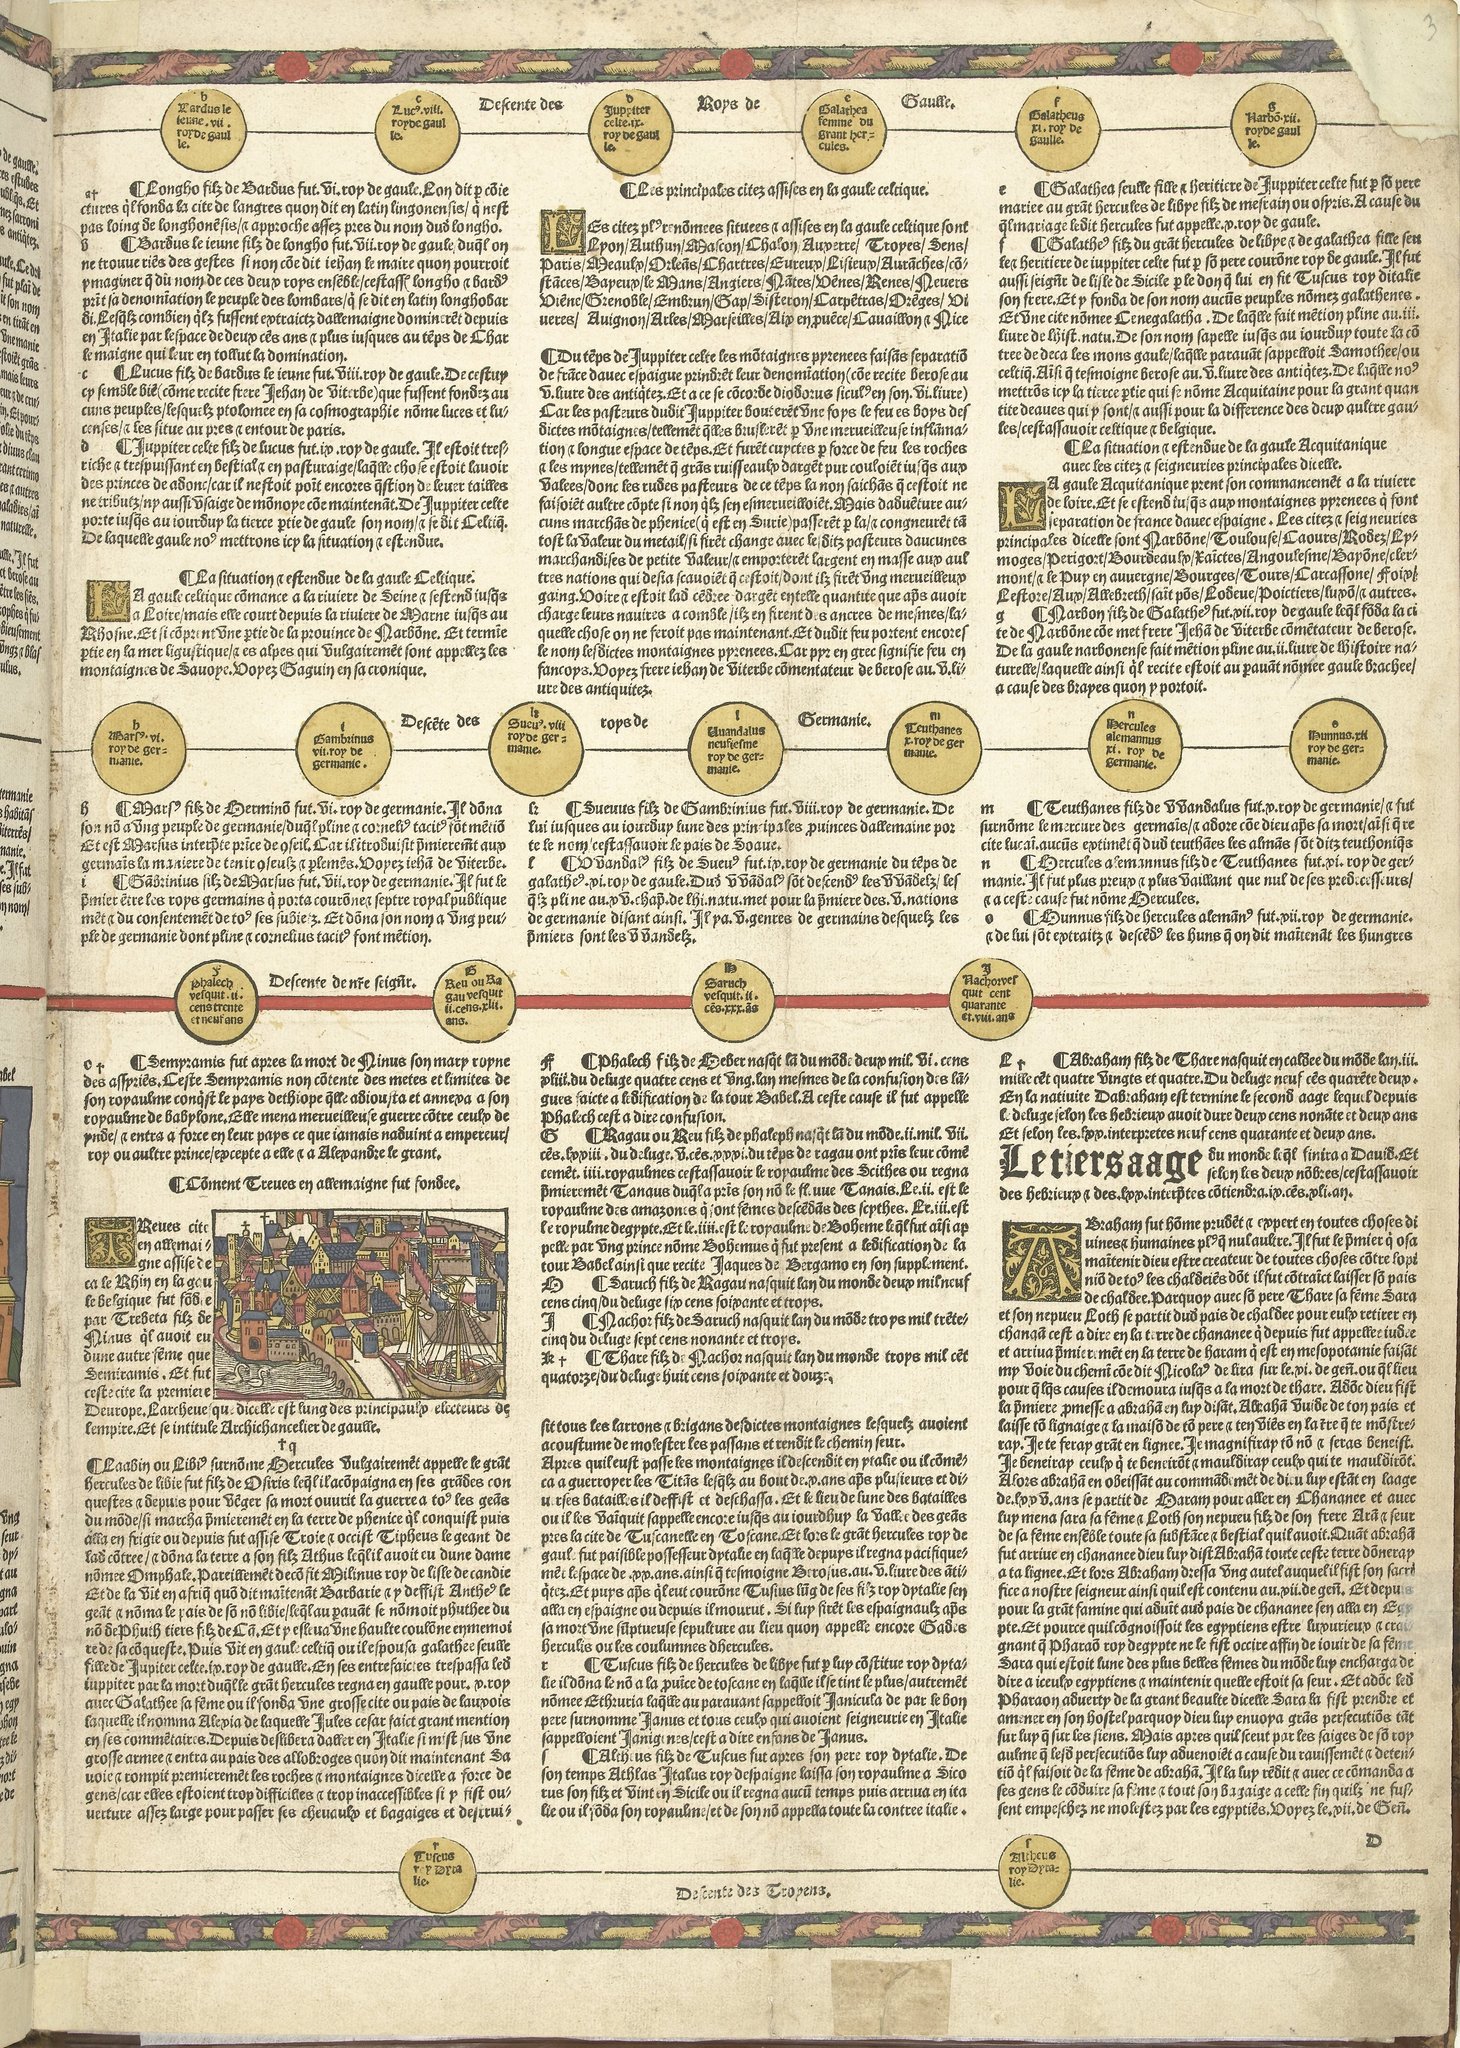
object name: album leaf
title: Cronica Cronicarum (...), blad 3 recto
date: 1521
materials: paper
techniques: letterpress printing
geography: paris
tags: city-view in general; 'veduta'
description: Blad 3 recto van een wereldkroniek. Tekst in boekdruk in het Frans in drie kolommen met versierde initialen. Rechts midden een titel: Le tiers aage. Links een voorstelling van een stad aan een rivier. Cirkels die gevuld zijn met namen vormen samen een schematische weergave van genealogie en vorstenopvolging, die zich uitstrekt over meerdere bladzijden van de kroniek.